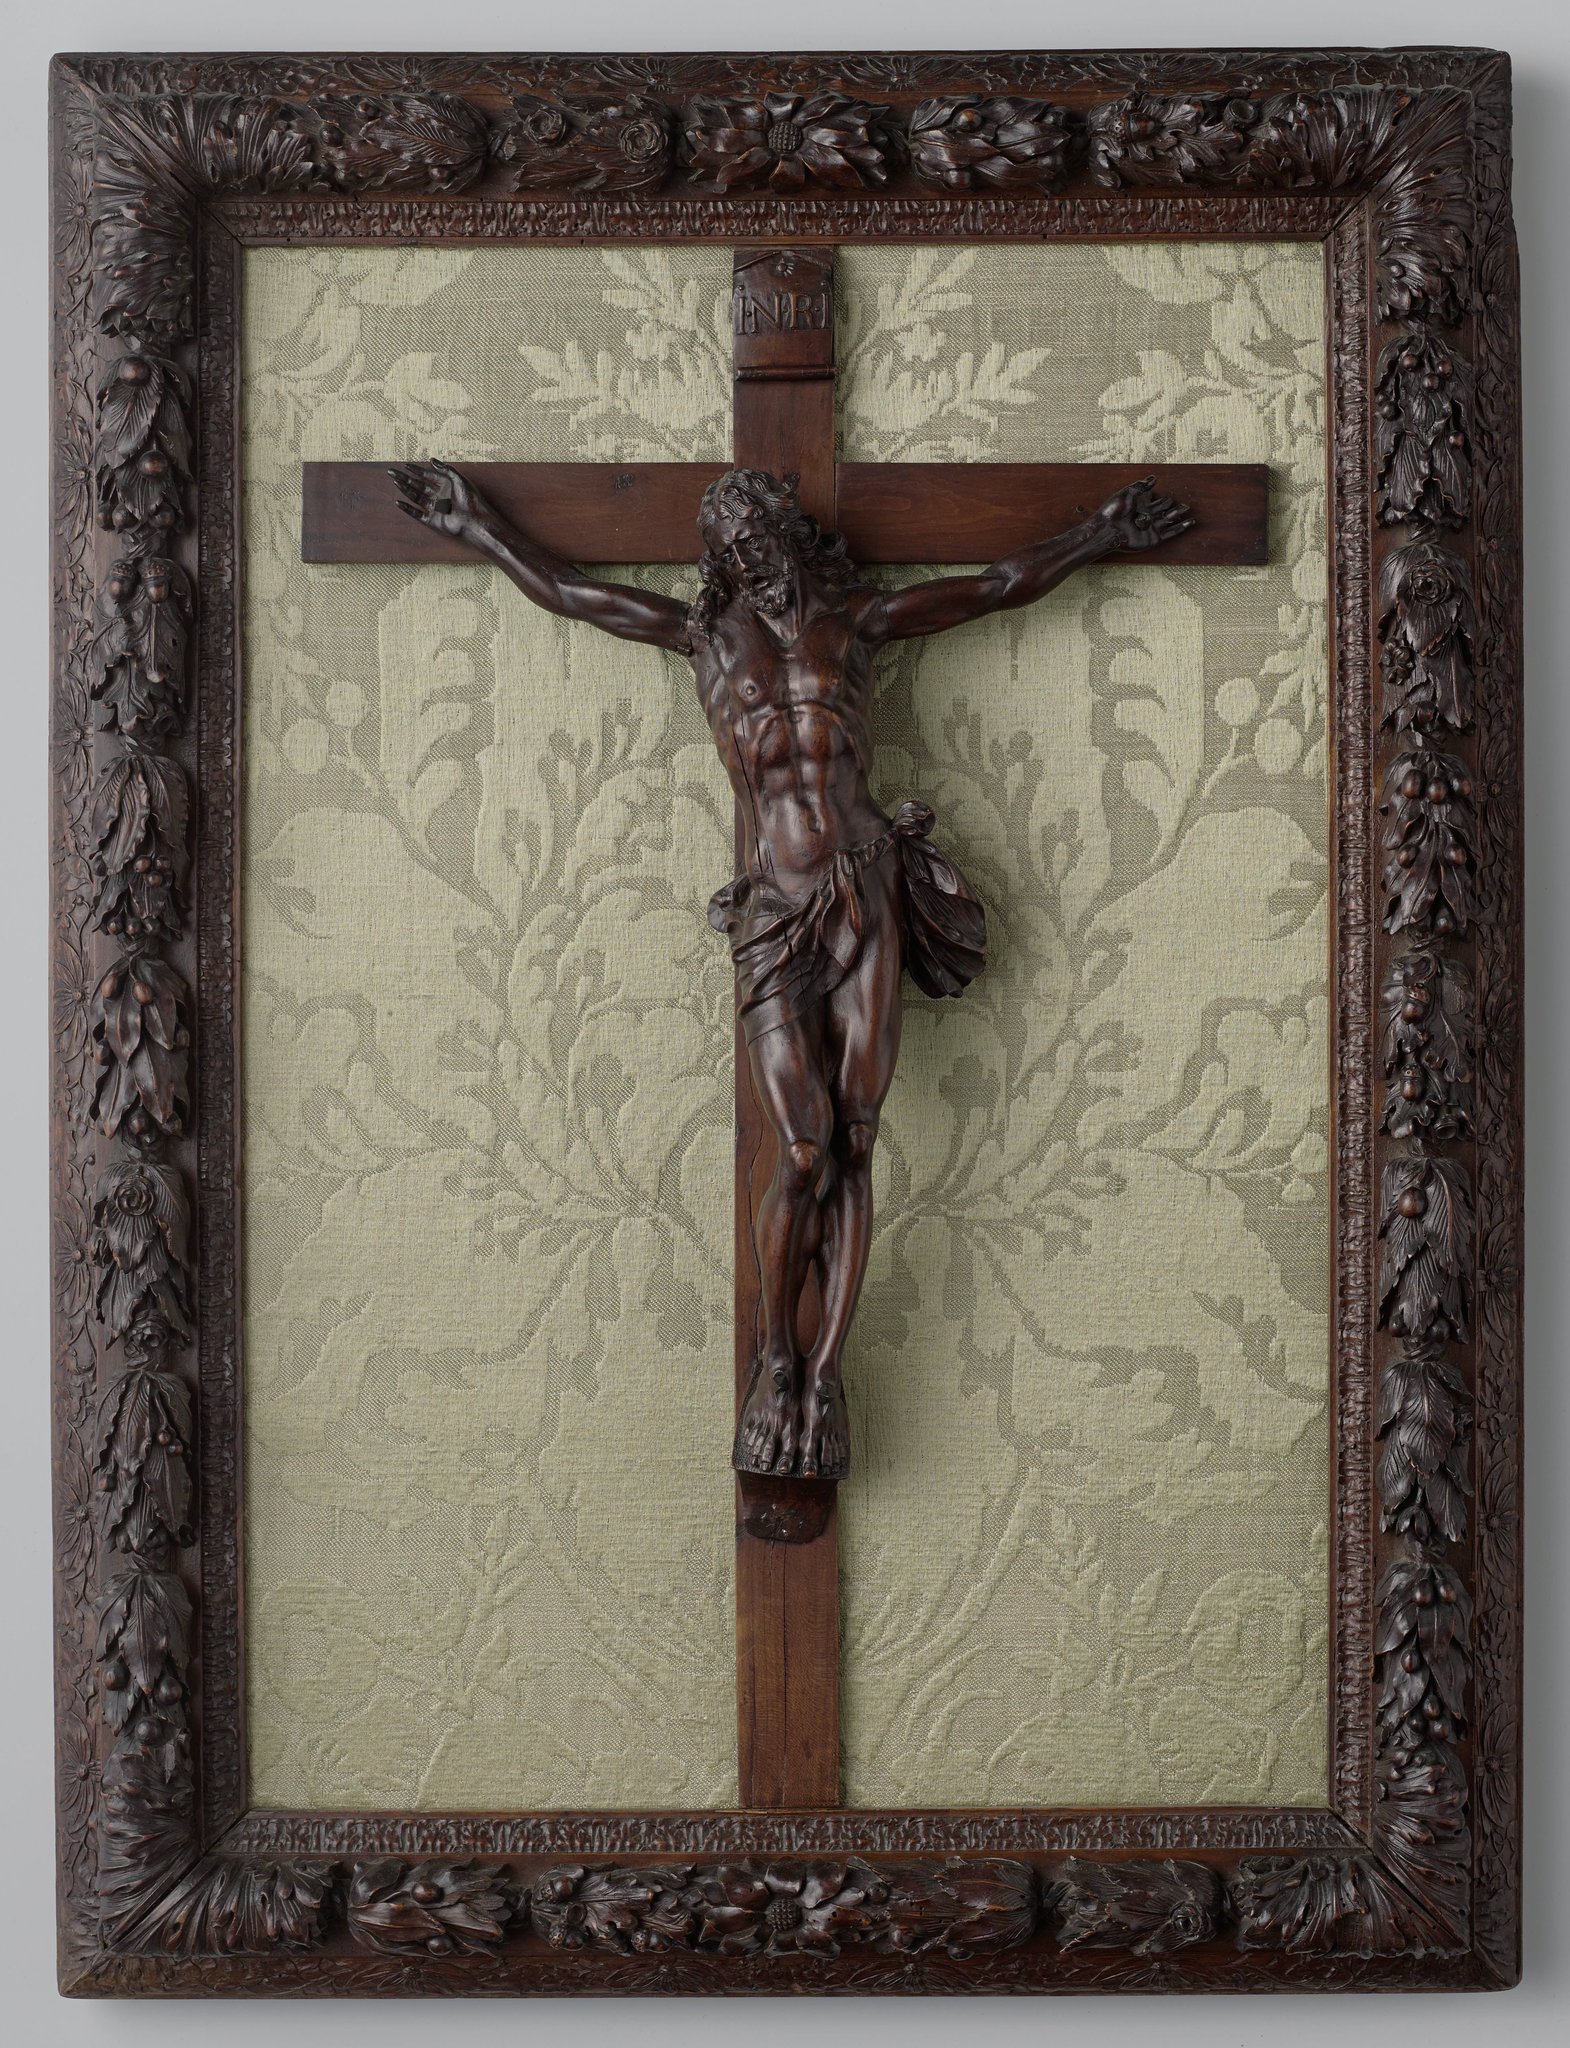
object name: sculpture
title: Corpus Christi in lijst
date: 1700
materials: wood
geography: france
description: Corpus Christi. Kersenhout. Frankrijk, ca. 1700.